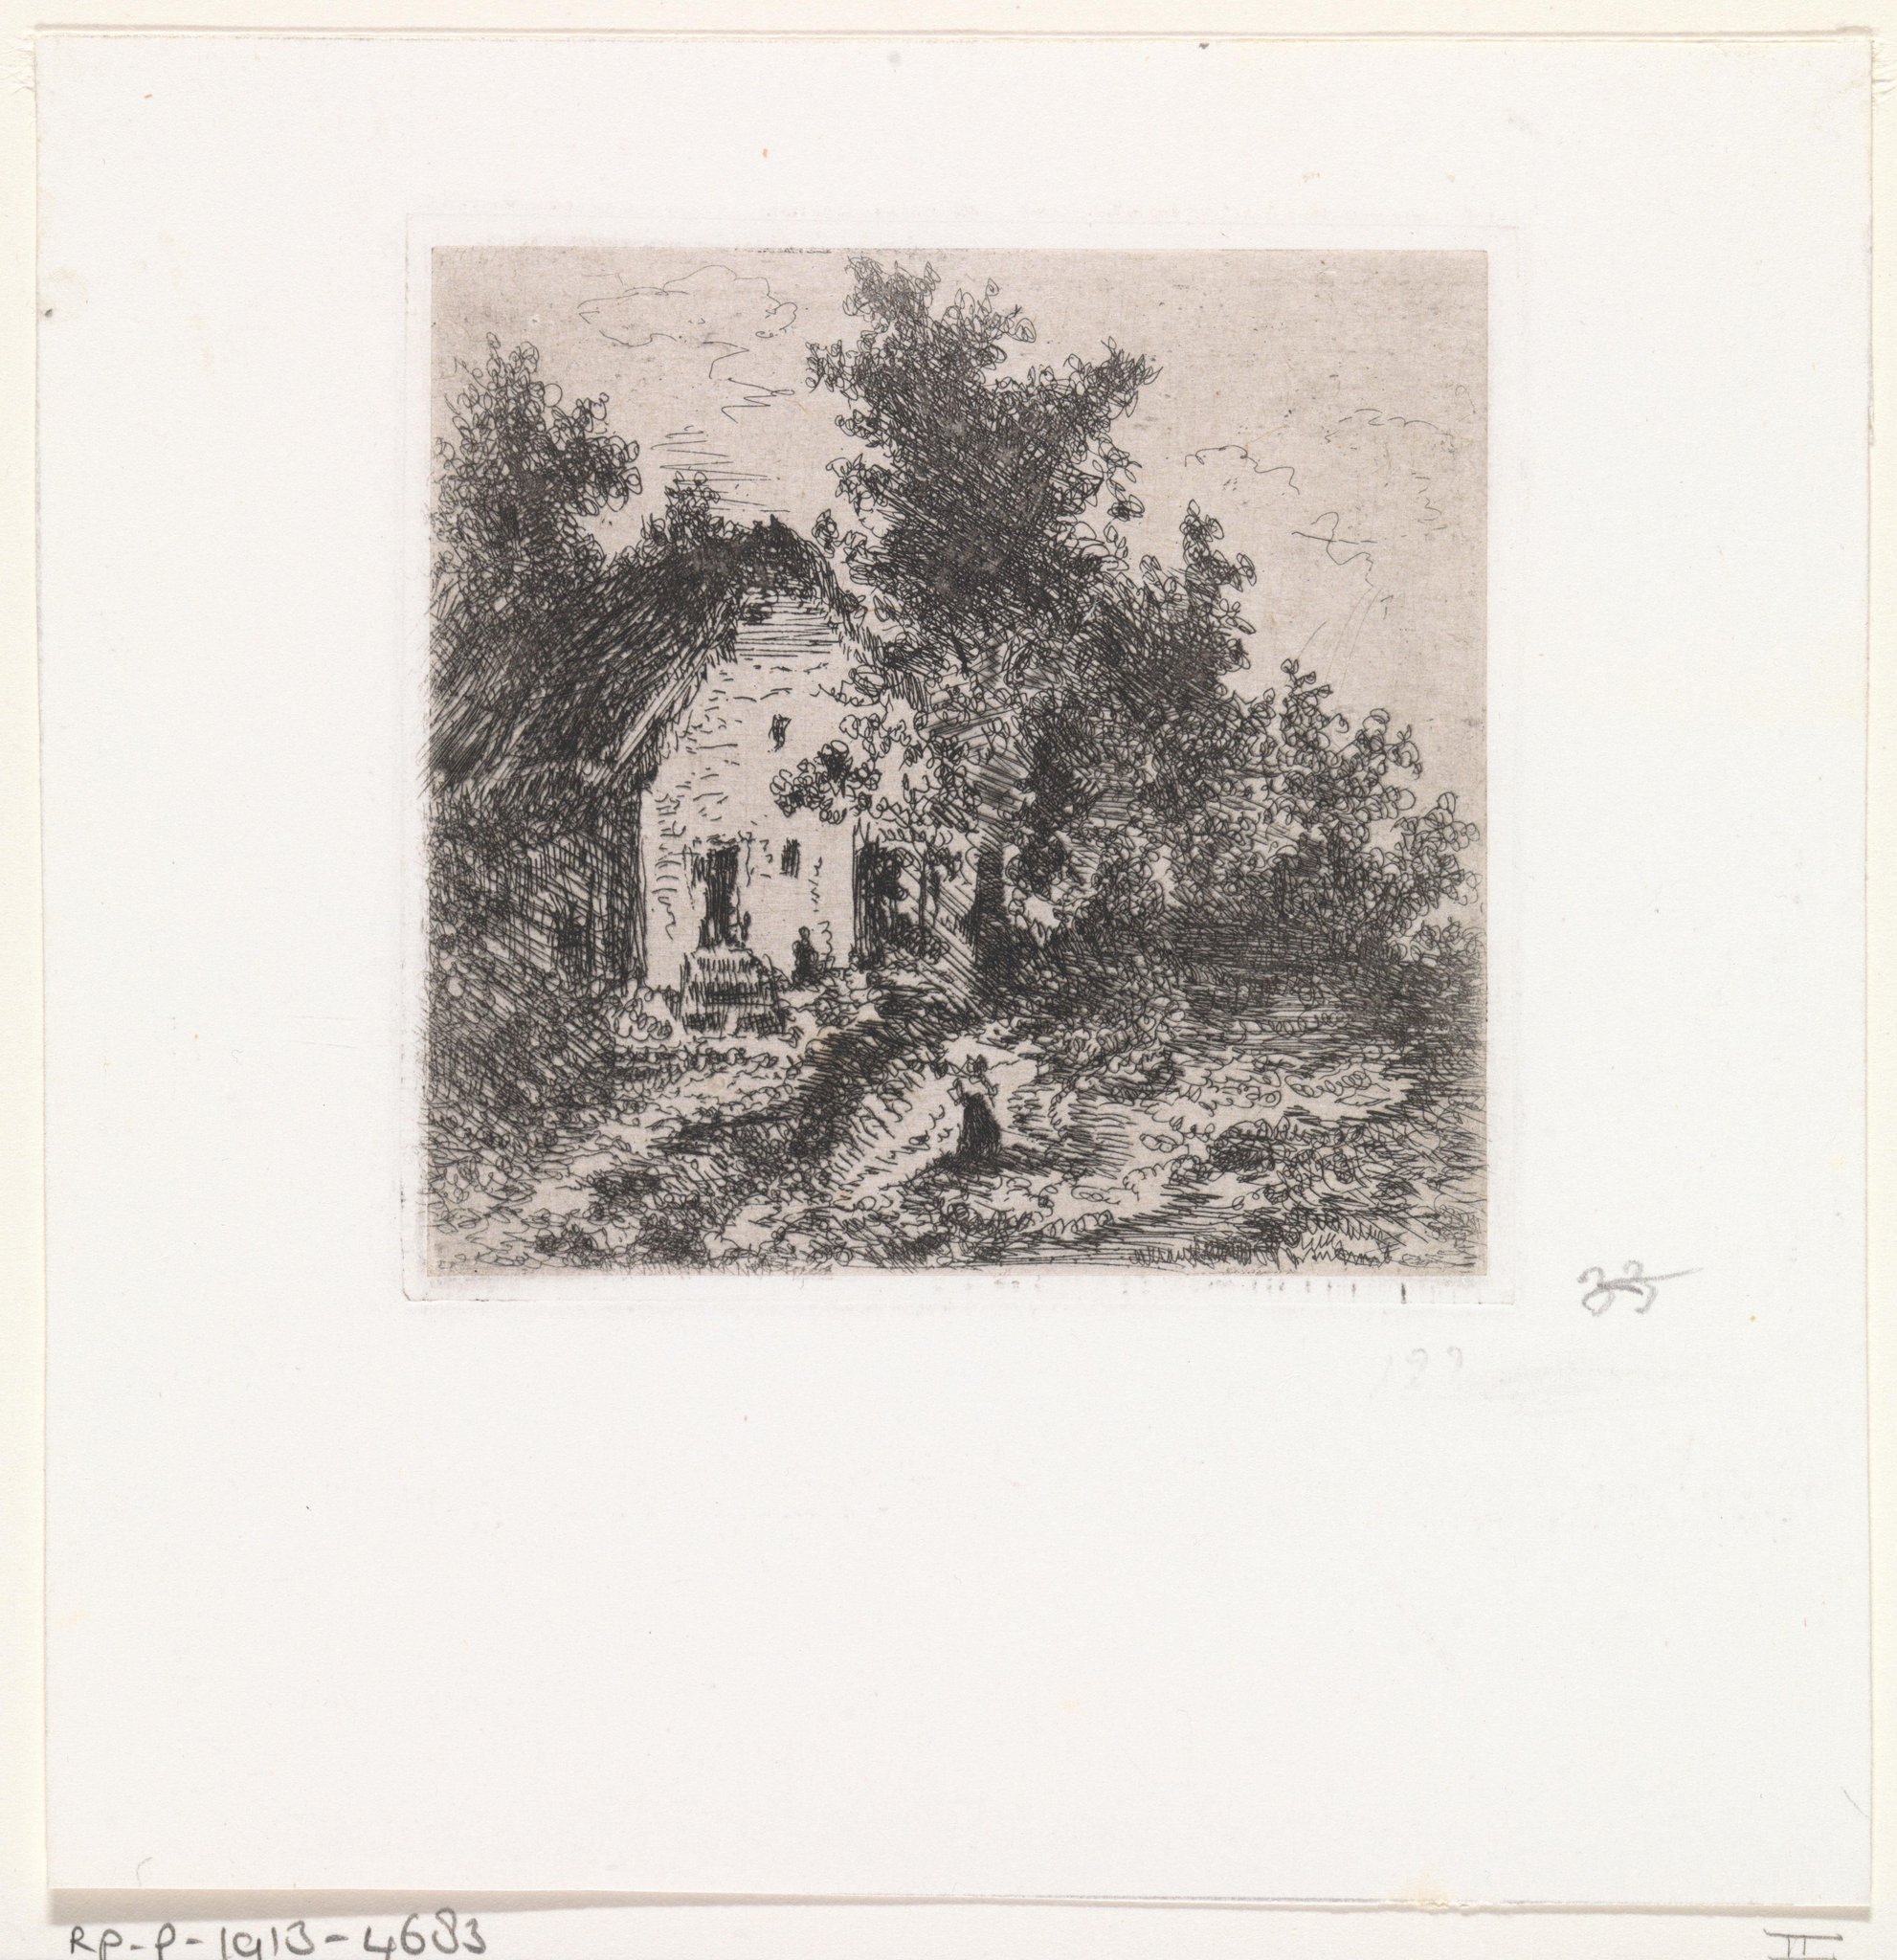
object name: print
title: Boerderij onder bomen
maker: arnoud schaepkens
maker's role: print maker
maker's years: 1816-1904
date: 1855-1904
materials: paper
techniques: drypoint, etching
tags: farm or solitary house in landscape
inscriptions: collector's mark: Lugt 2228